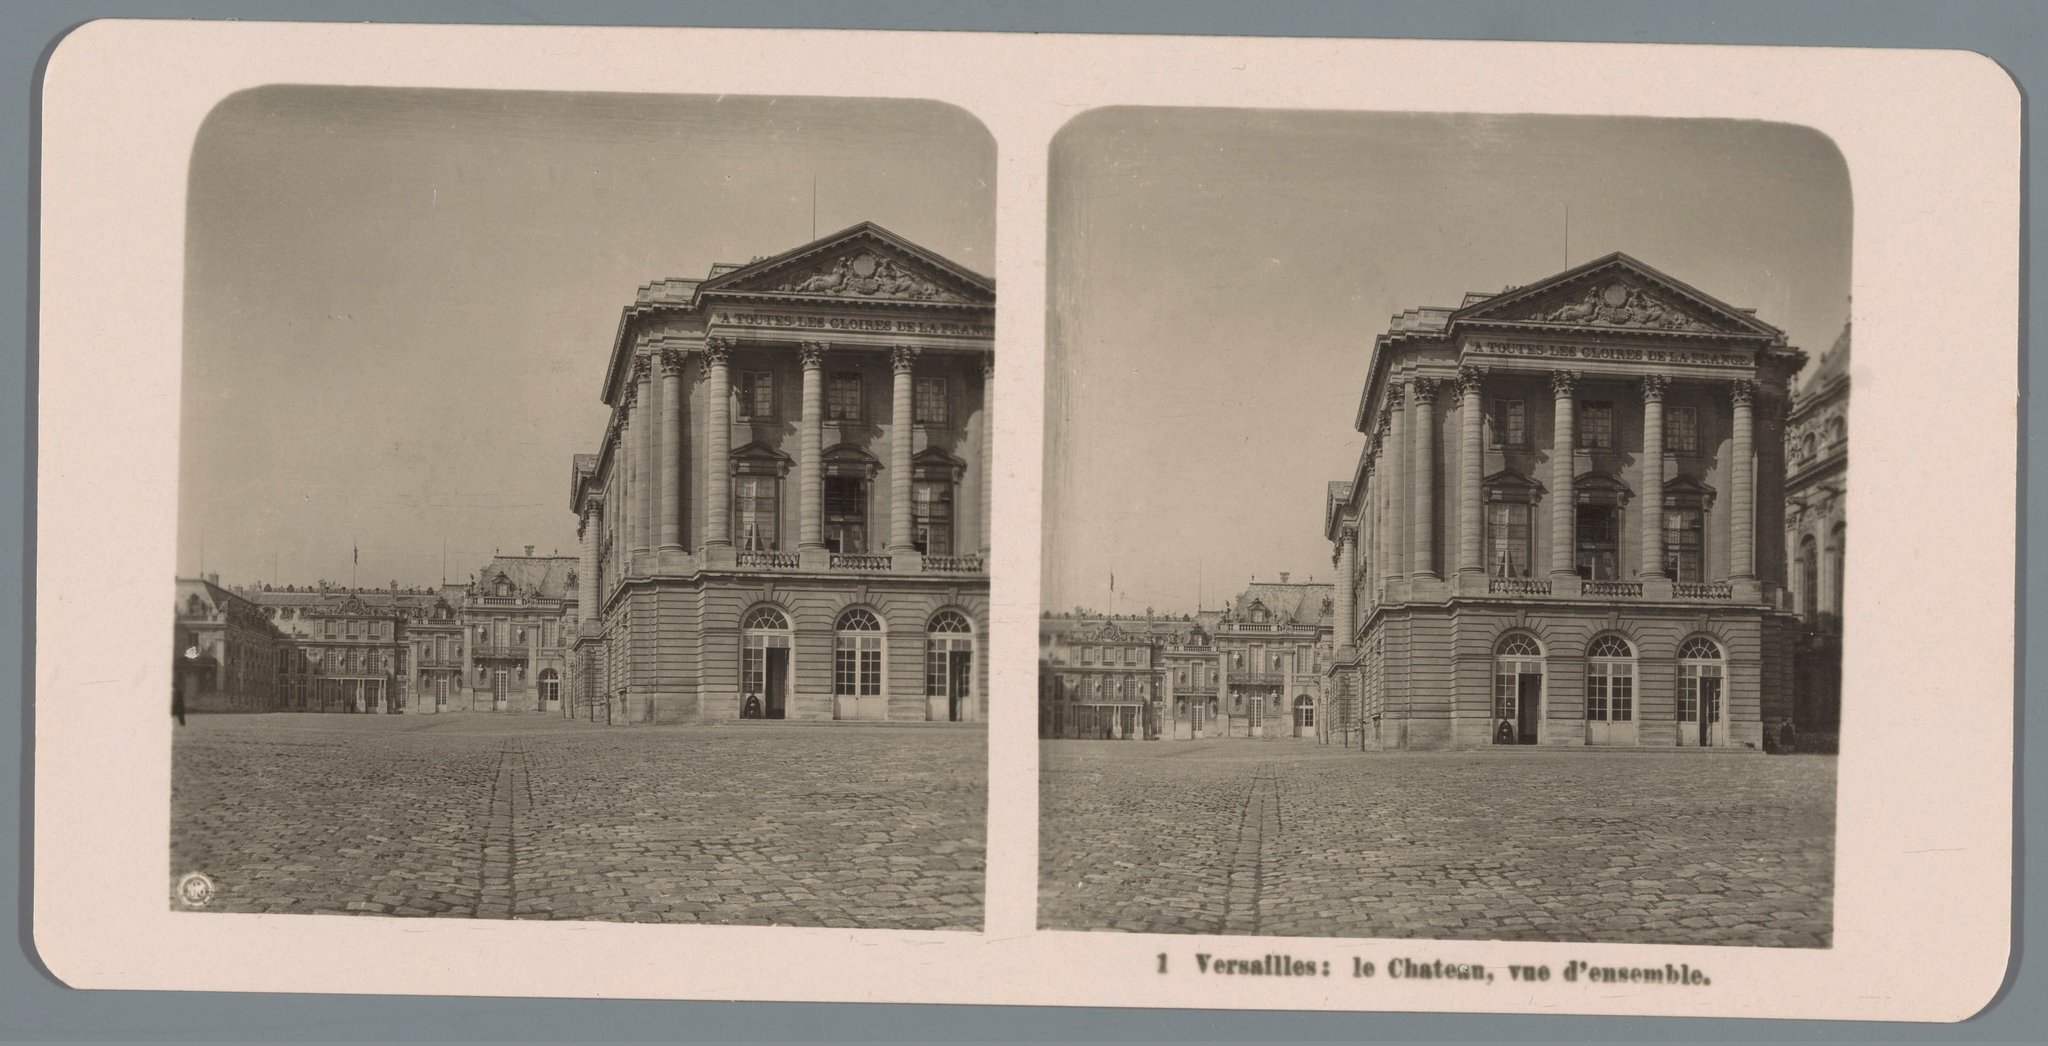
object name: stereograph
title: Versailles: le Chateau, vue d'ensemble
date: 1894-1910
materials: cardboard, photographic support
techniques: gelatin silver print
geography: versailles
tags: castle, façade (of house or building)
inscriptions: number: ‘1’, inscription: ‘NPG’